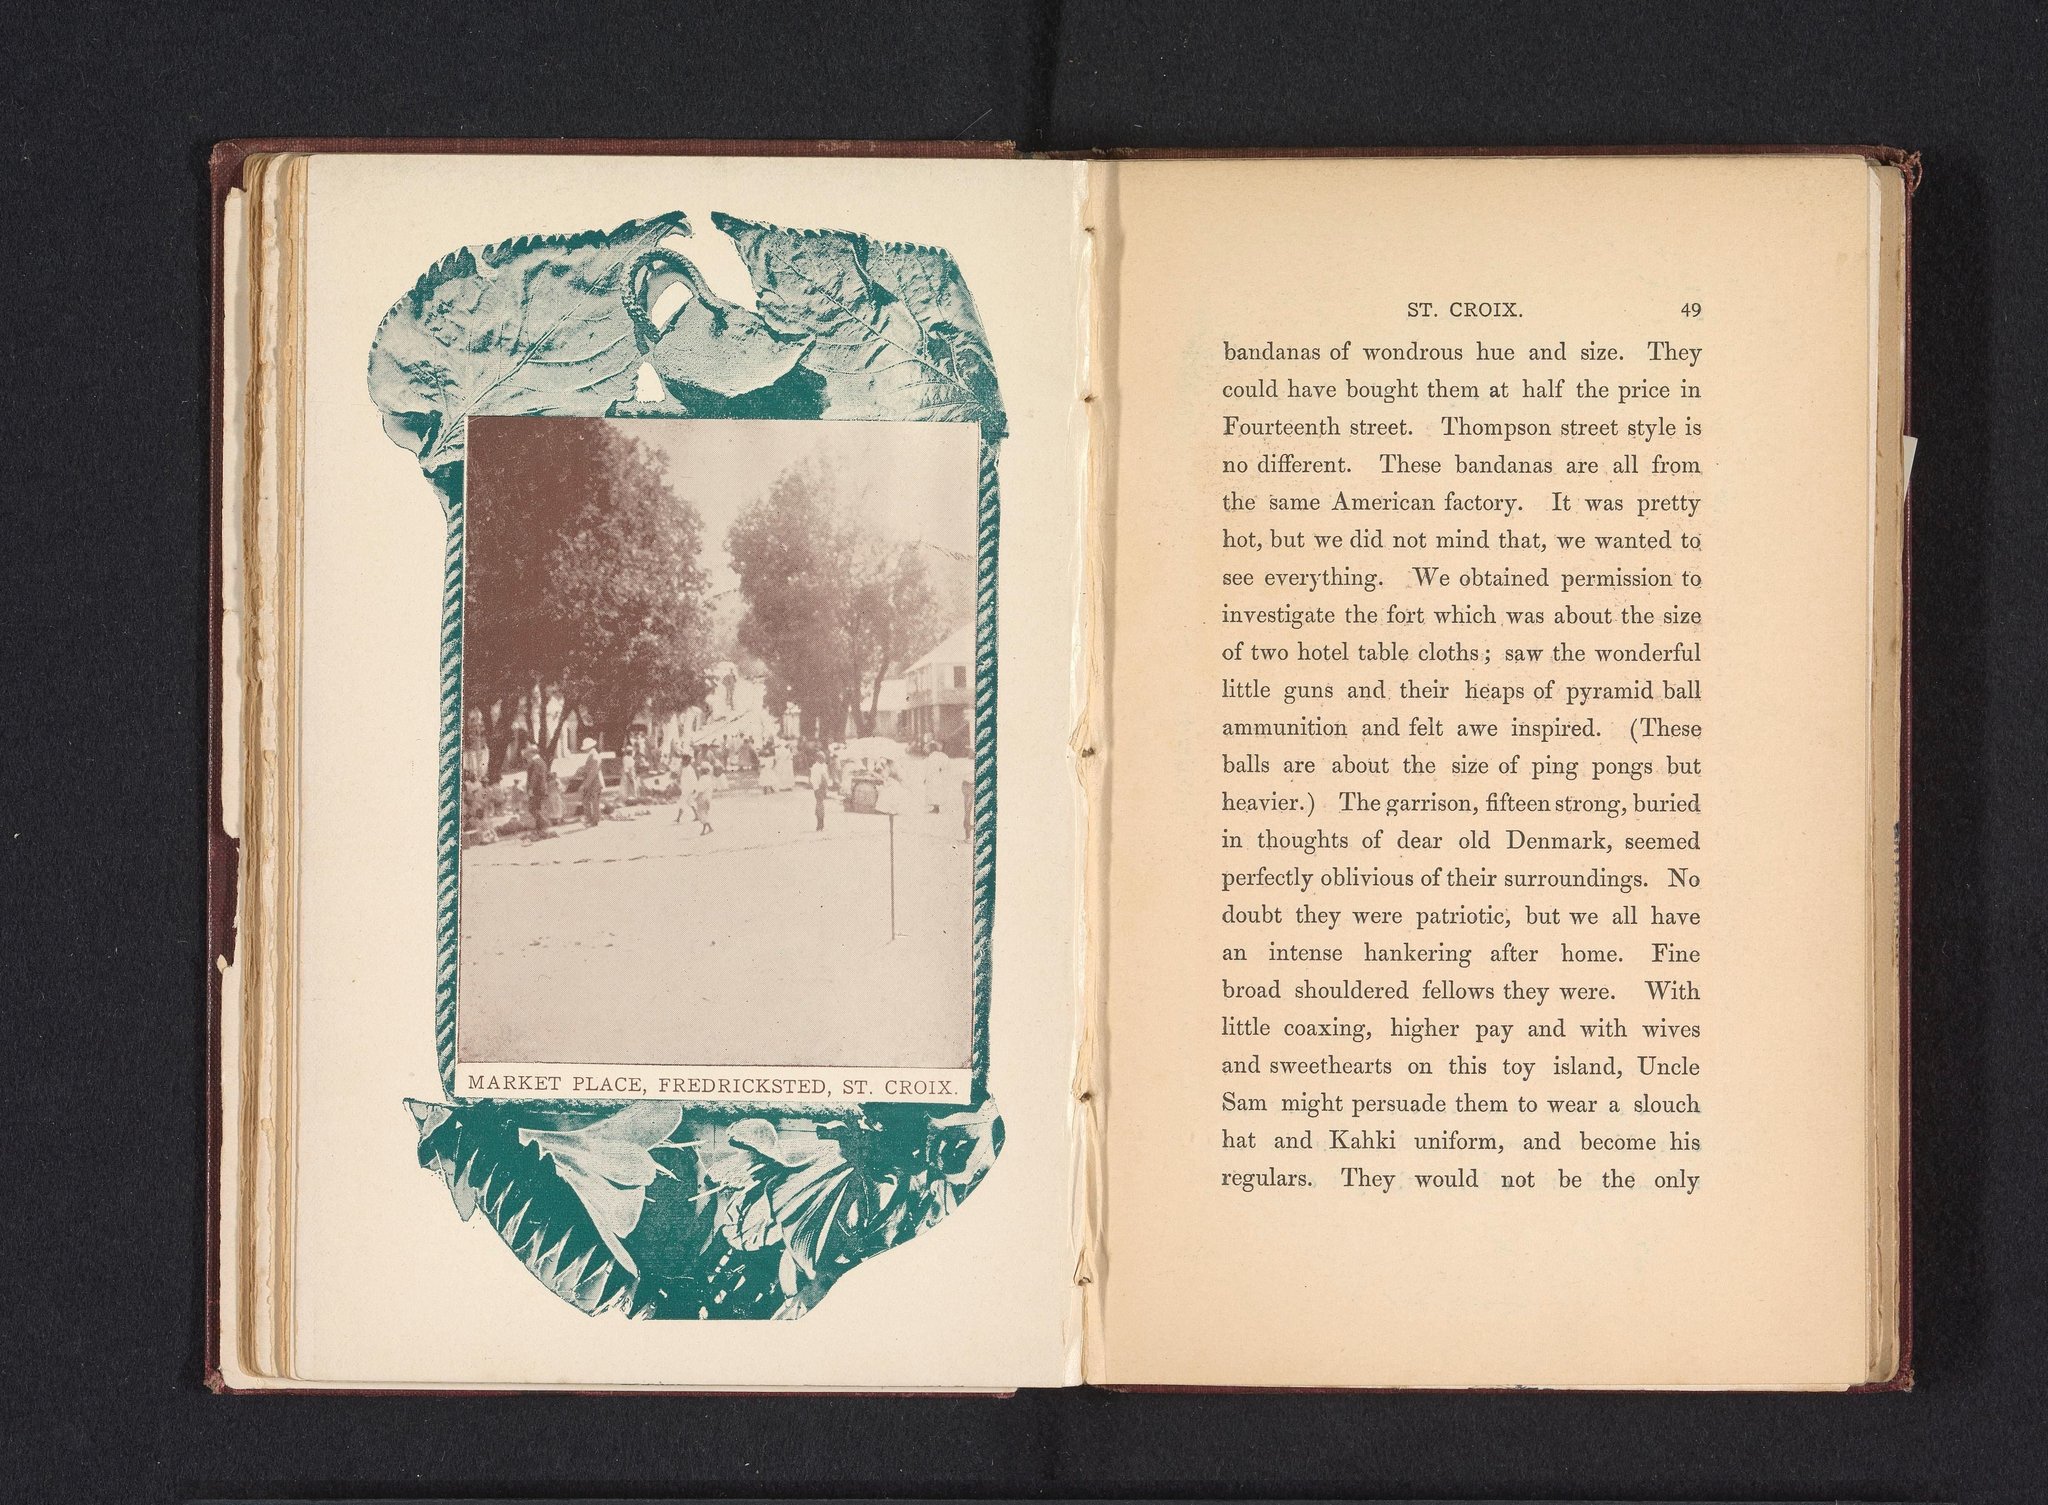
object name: page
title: Gezicht op een markt in Frederiksted op Saint Croix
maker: Anonymous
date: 1892-1902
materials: paper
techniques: autotype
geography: frederiksted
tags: market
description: Prent in apart gedrukte omlijsting met bladmotief.